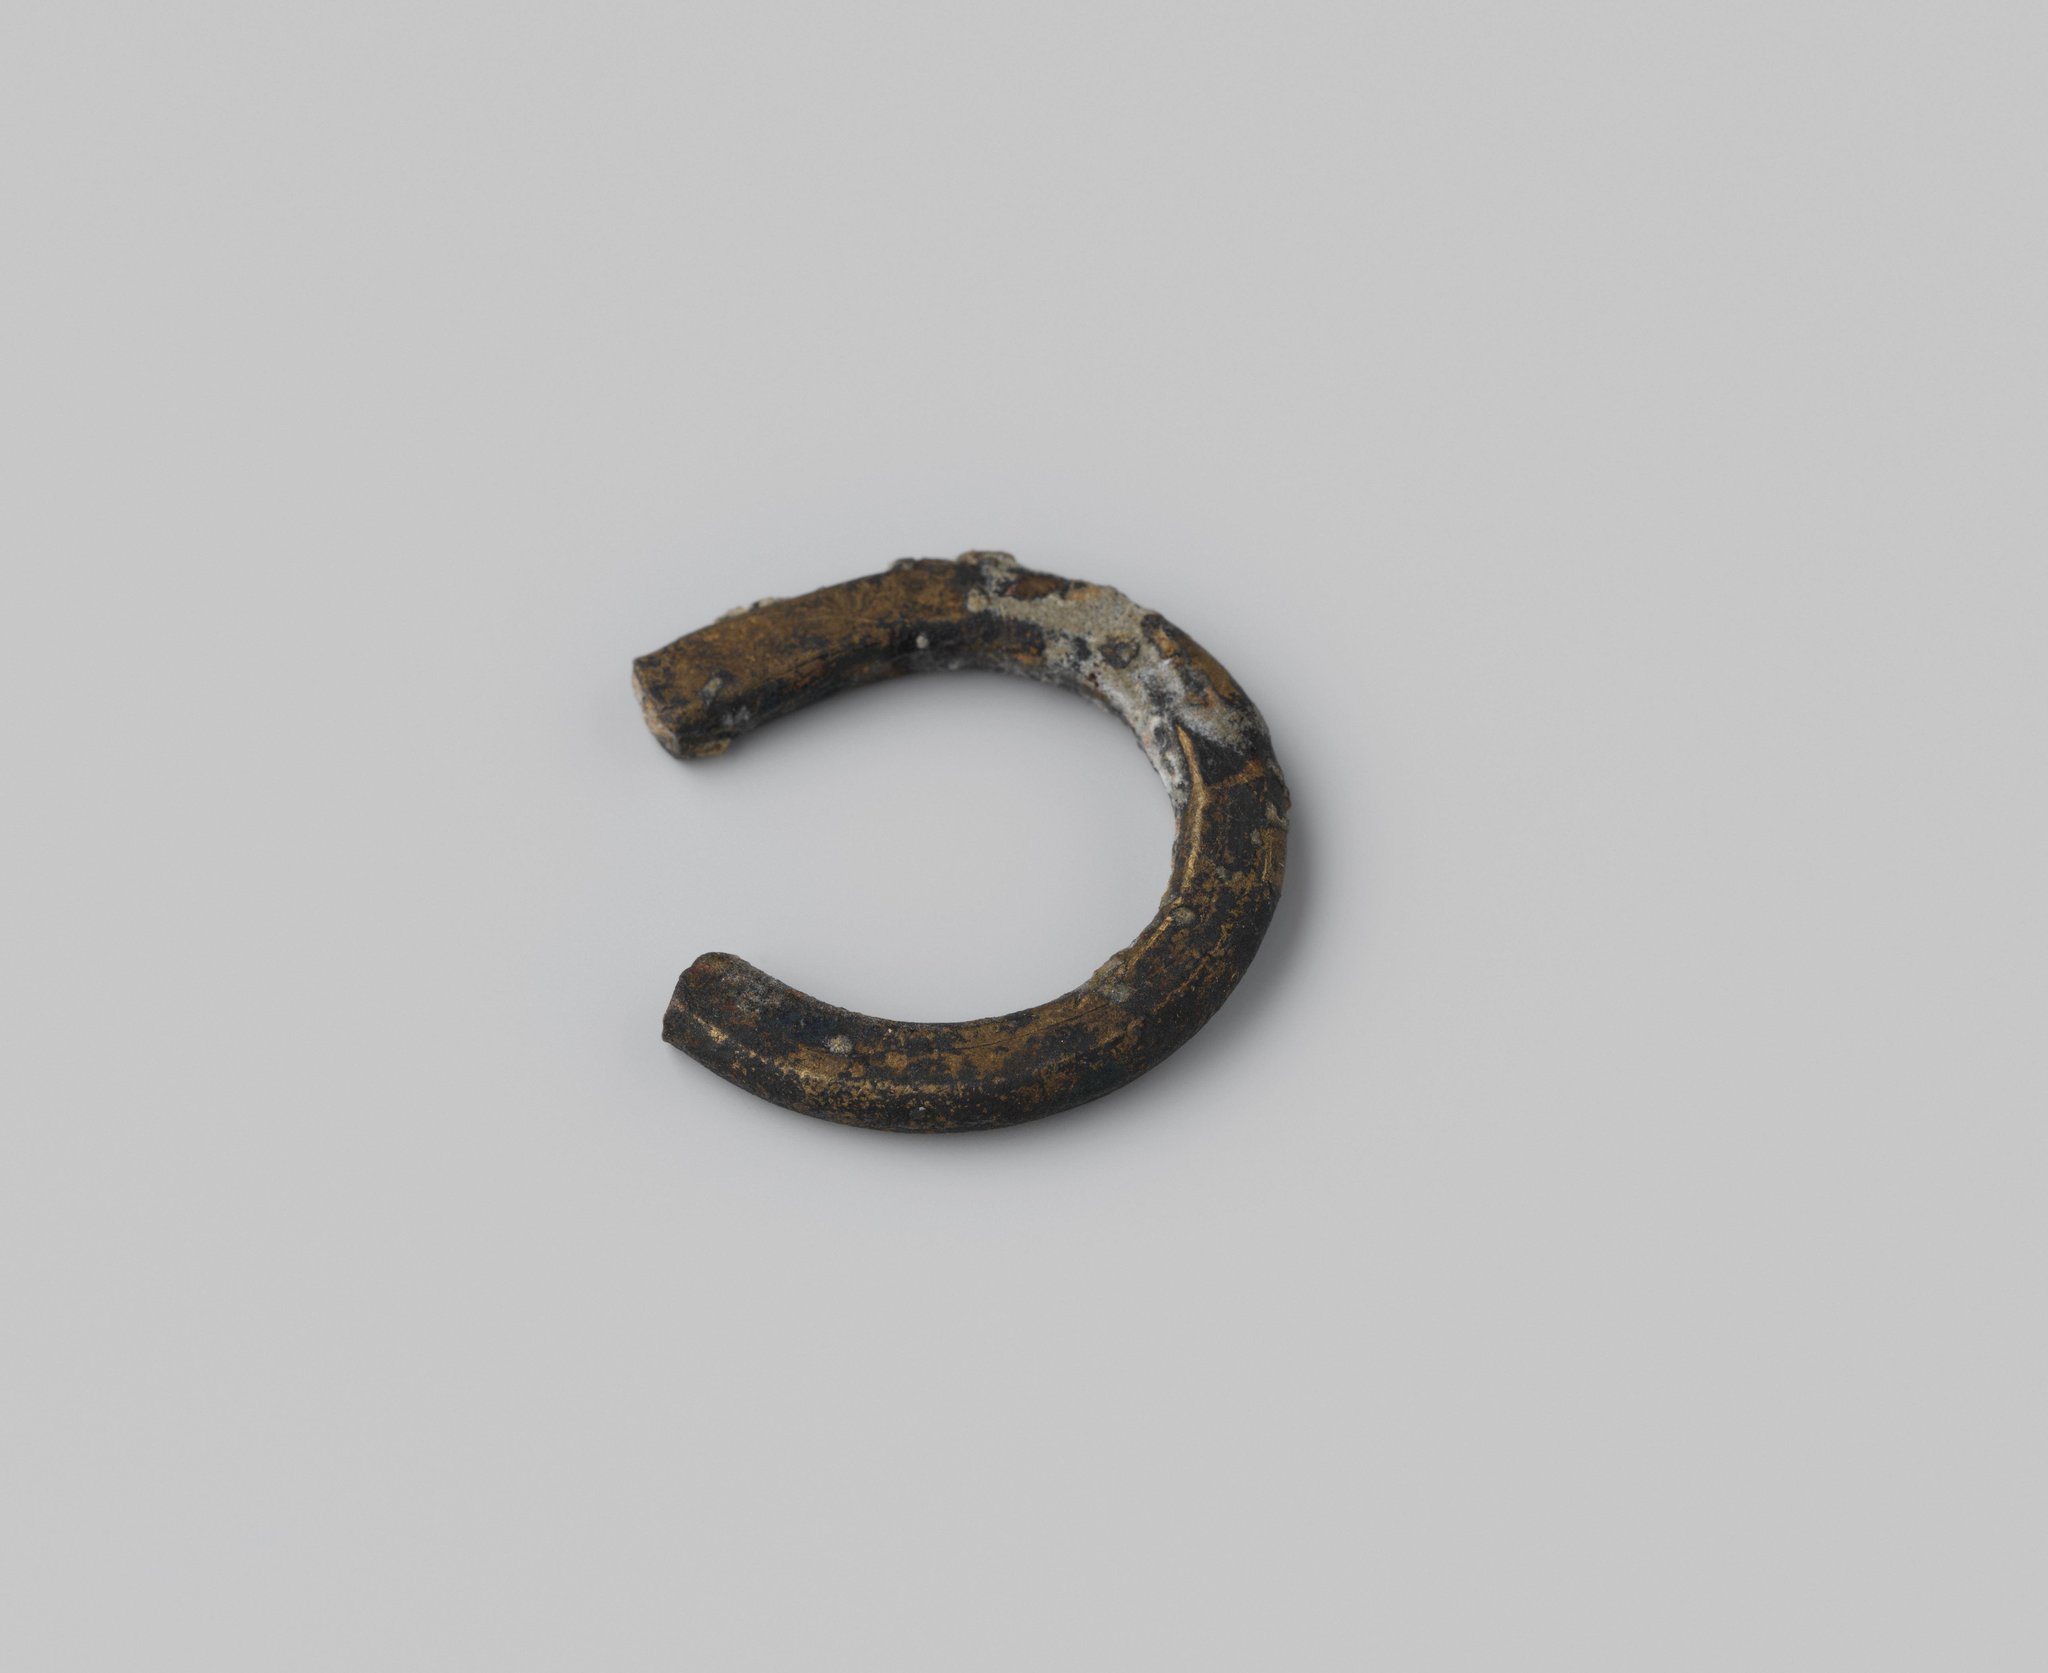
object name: ring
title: Hoefijzervormig fragment uit het wrak van de Oost-Indiëvaarder Hollandia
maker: Anonymous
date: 1700-1743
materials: copper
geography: netherlands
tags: verenigde oostindische compagnie, hollandia (schip), annet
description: Varied parts or fragments, rings or ring-shaped fragments; fragm, horseshoe-shaped, both ends broken off, flat in section.